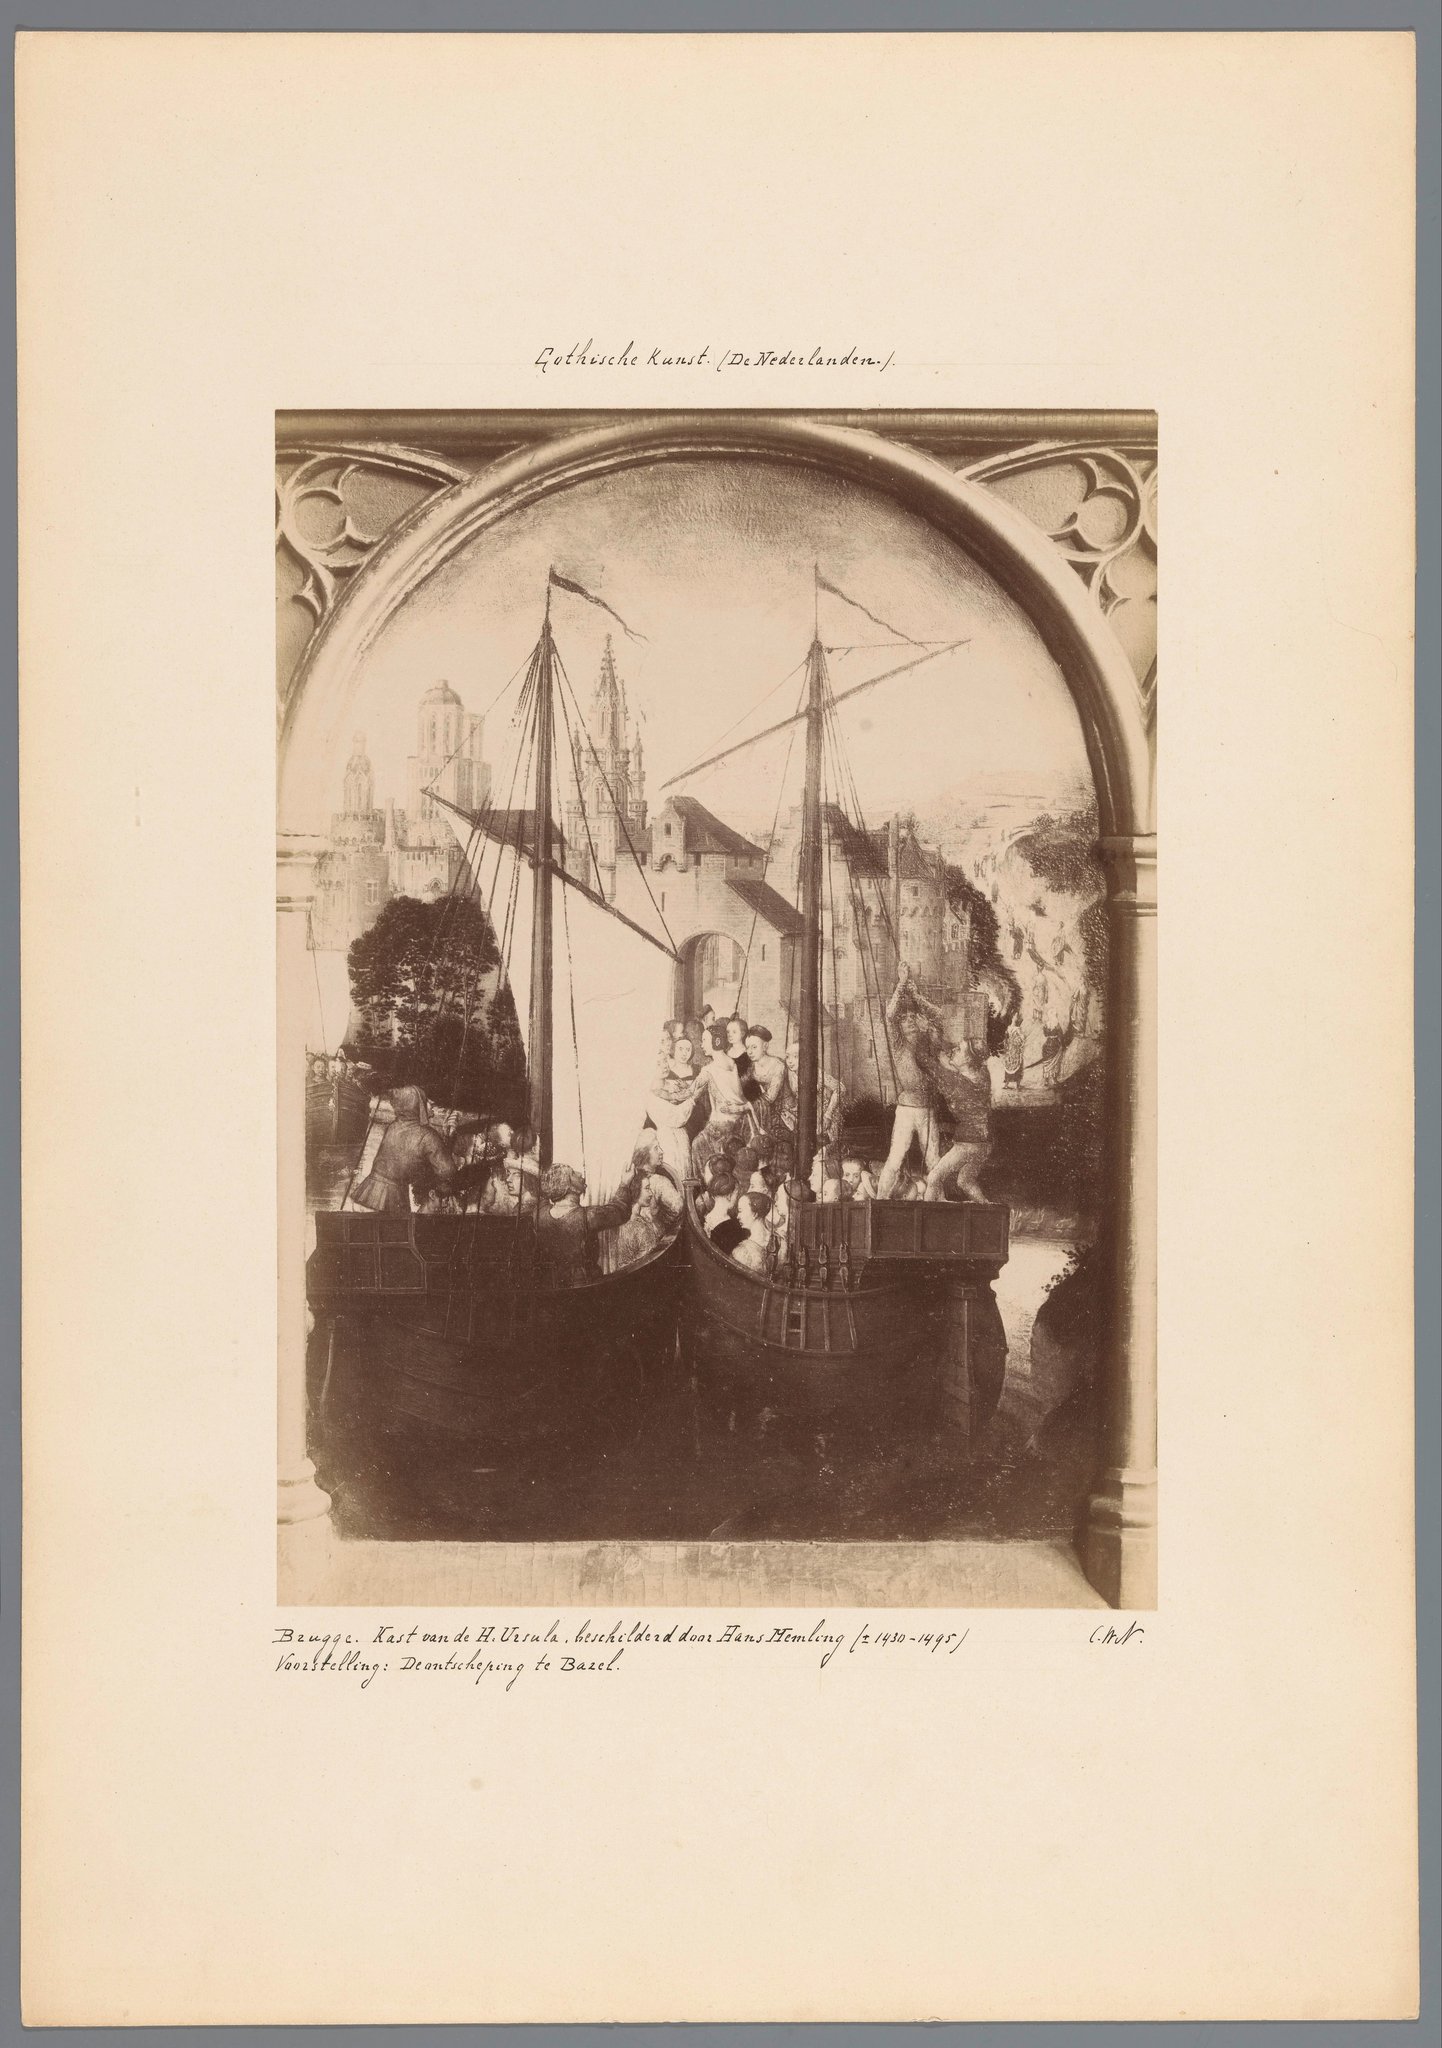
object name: photograph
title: Schildering op de Ursulaschrijn door Hans Memling, voorstellende de aankomst van de heilige Ursula te Basel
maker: Anonymous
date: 1875-1900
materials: cardboard, photographic support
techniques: albumen print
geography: bruges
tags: the virgin martyr ursula of cologne; possible attributes: arrow, banner with red cross, cloak of ermine, crown, ship, relics (and reliquaries), picture, painting, bruges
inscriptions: collector's mark: ‘INSTITUUT VOOR KUNST- NIJVERHEIDSONDERWIJS GABRIËL METSUSTRAAT No. 16. AMSTERDAM’, collector's mark: ‘KUNSTNIJVERHEIDSCHOOL QUELLINUS AMSTERDAM FRANS HALSSTRAAT 14.’, inscription: ‘Gothische Kunst. De Nederlanden. Brugge. (...) Voorstelling: De Ontscheping te Bazel.’, inscription: ‘CWN.’